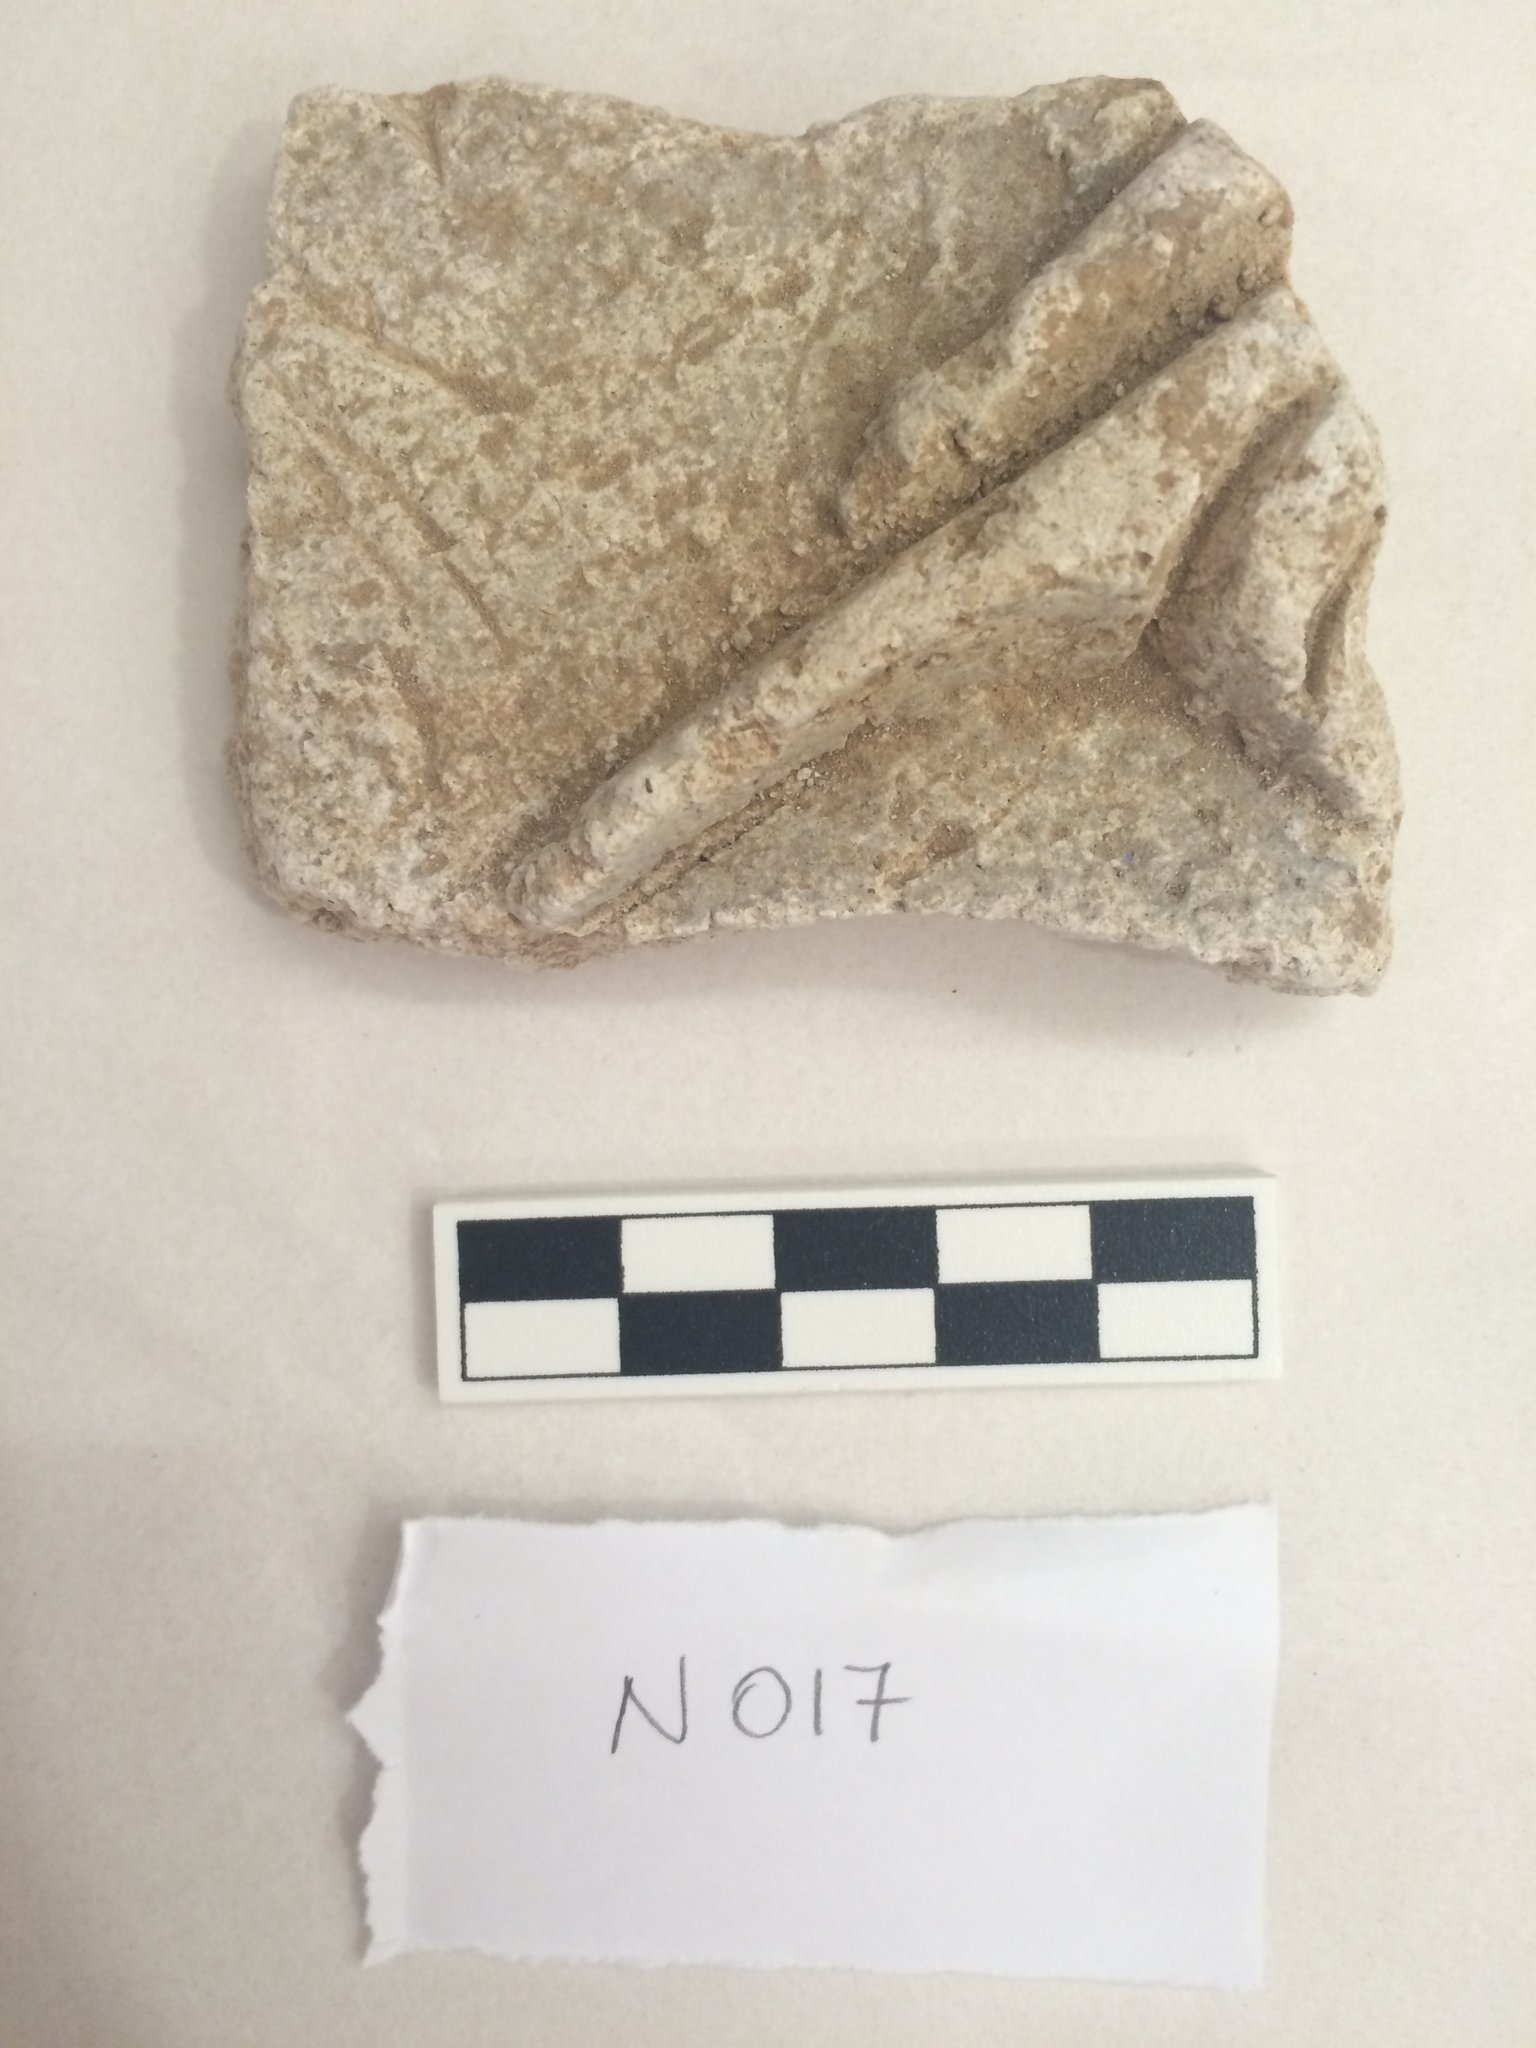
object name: fragment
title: Stucco Fragment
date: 701-1200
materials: plaster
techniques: carving, painting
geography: iran